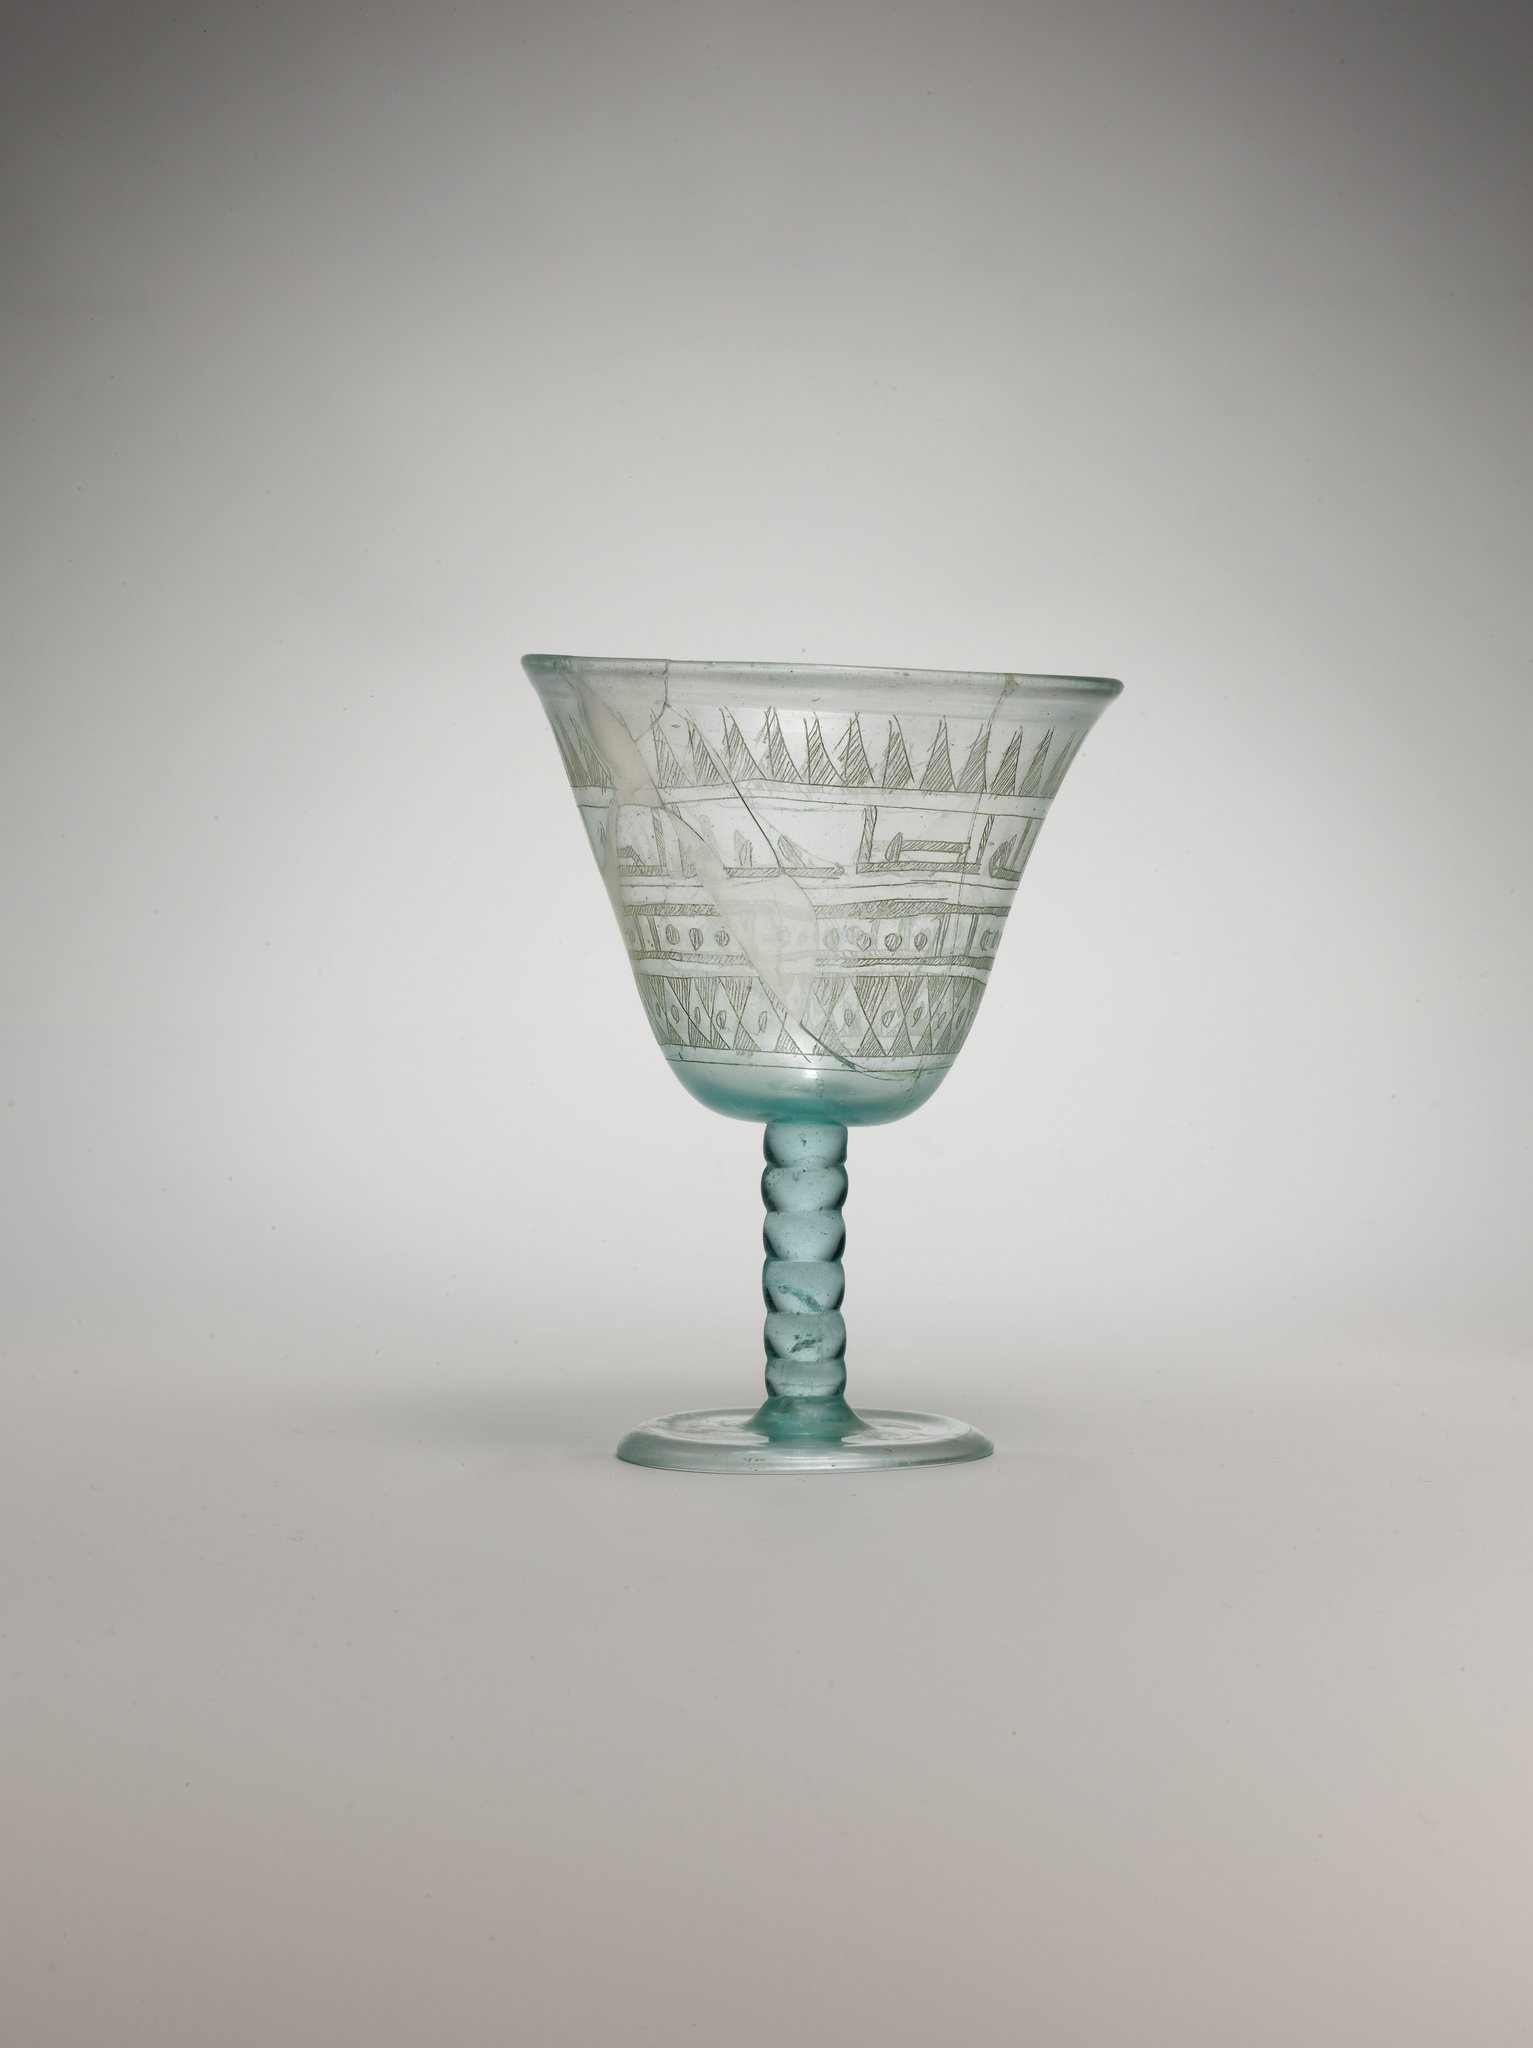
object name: goblet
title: Goblet with Incised Designs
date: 701-900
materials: glass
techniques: glassblowing, engraving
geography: iraq